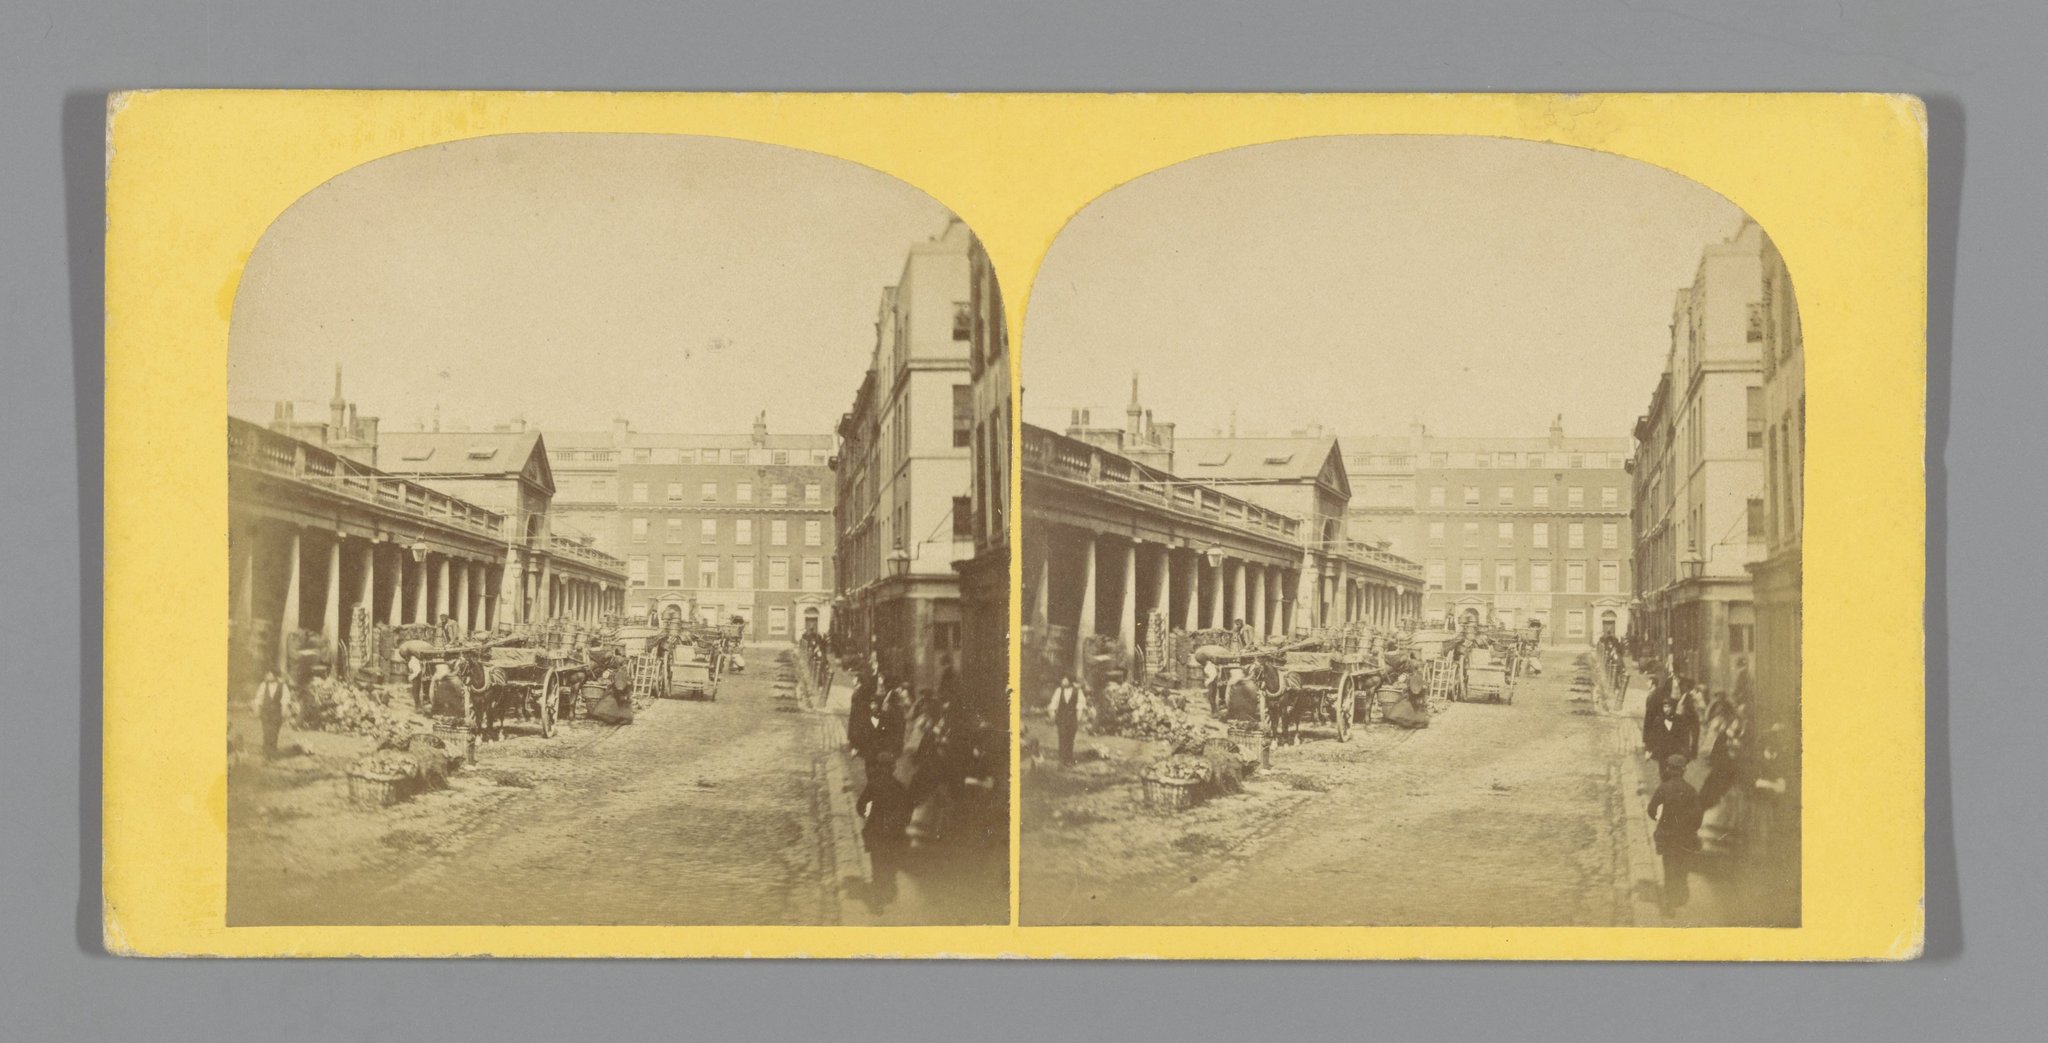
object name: stereograph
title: Instantaneous Views of London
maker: Anonymous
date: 1850-1880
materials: cardboard, photographic support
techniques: albumen print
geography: london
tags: two-wheeled, animal-drawn vehicle, market-hall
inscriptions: inscription, number: ‘No. 182.’